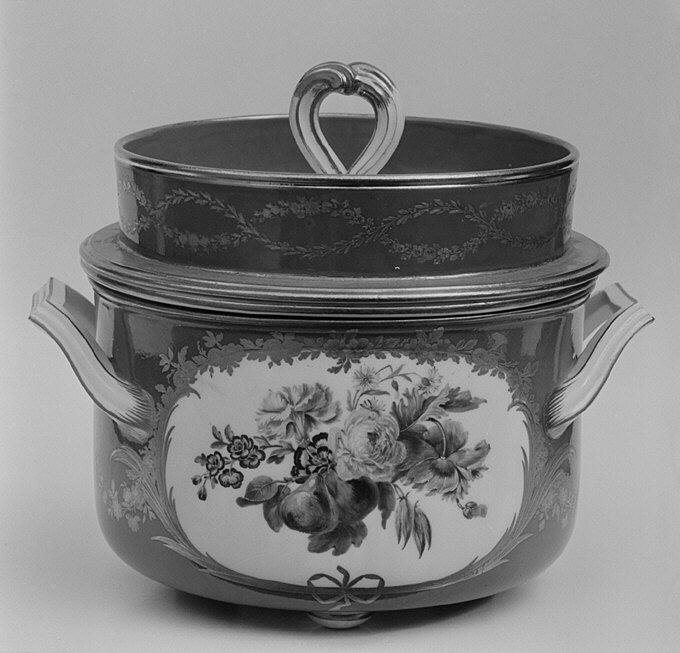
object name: ice pail with cover and liner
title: Ice pail with cover and liner (seau à glace) (one of three) (part of a service)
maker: sèvres manufactory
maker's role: manufactory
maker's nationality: french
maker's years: 1740-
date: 1770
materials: soft paste porcelain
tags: flowers